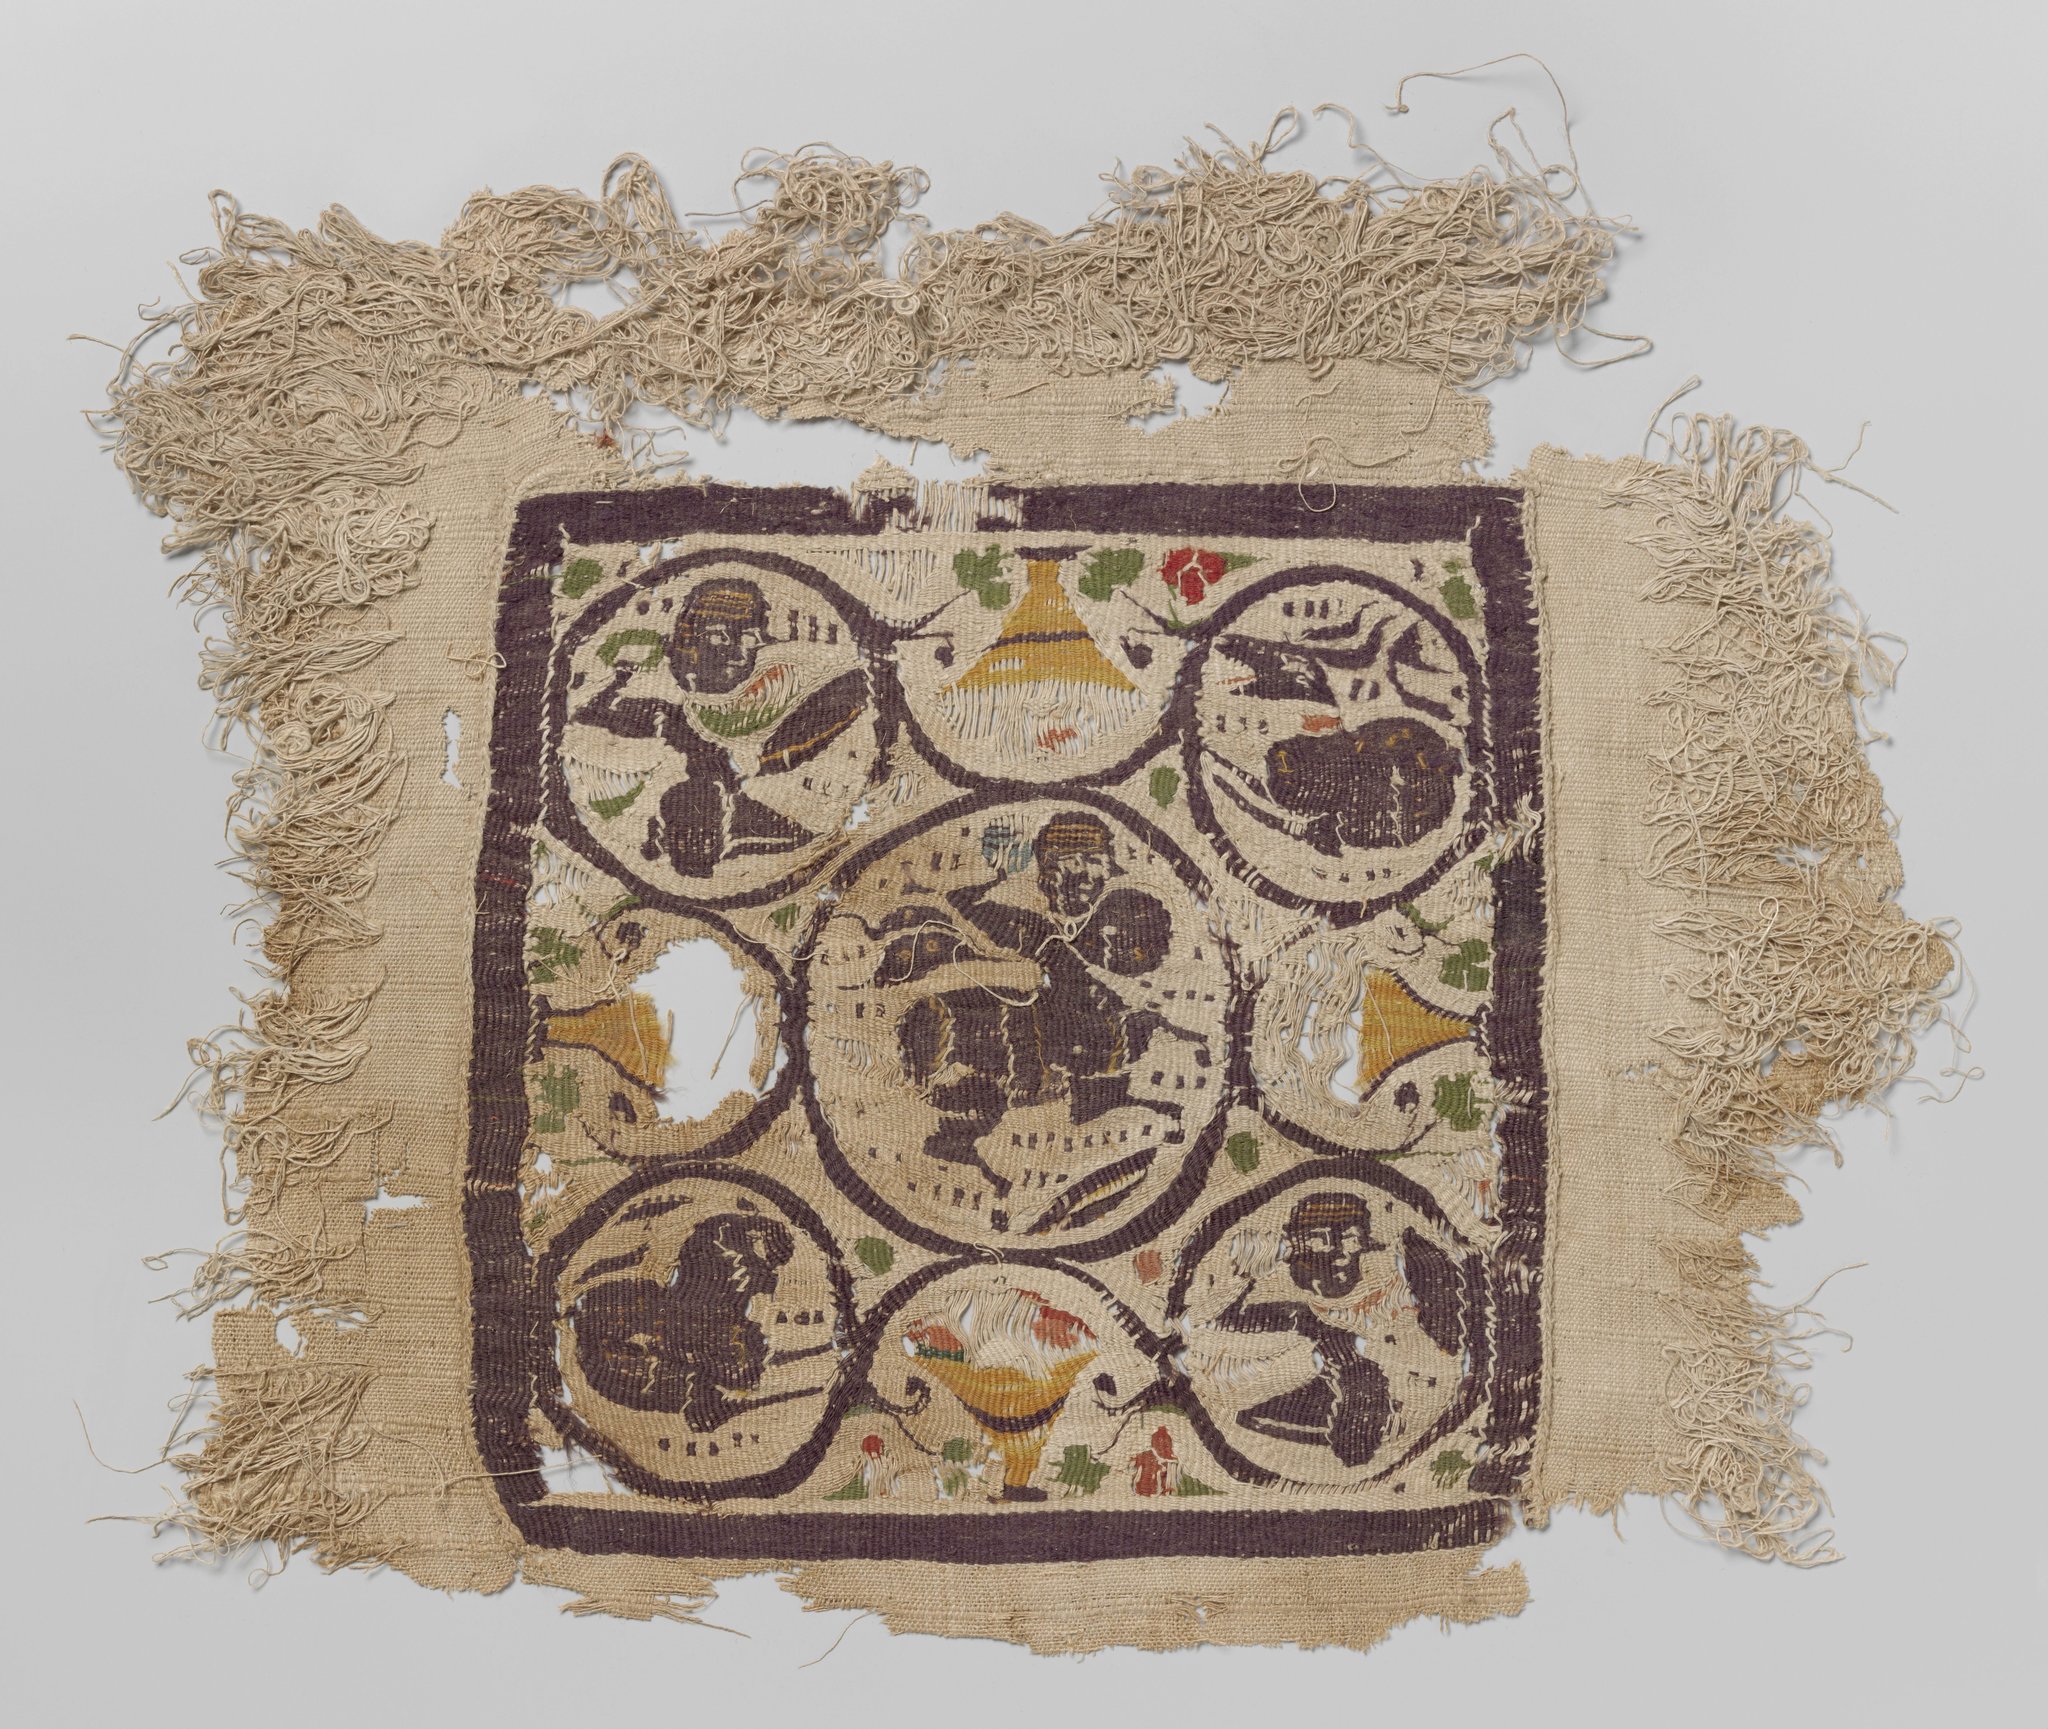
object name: tabula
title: Weefselfragment met tabula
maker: Anonymous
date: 300-699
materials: linen, wool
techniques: weave, tapestry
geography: egypt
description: Naturelkleurig linnen weefselfragment met ingeweven tabula met vijf cirkels in bordeauxrood. In de centrale cirkel een centaur, in de cirkels linksboven en rechtsonder een geknielde figuur met schild en krans, rechtsboven een liggend hert en linksonder een liggend dier, mogelijk een os. De vlakken tussen de cirkels zijn gevuld met gele bloemen- of vruchtenmanden. Her en der zijn kleuraccenten in rood, groen en blauw. Voor de detaillering is de vliegende draadtechniek gebruikt. Langs drie kanten zijn restanten van lussenweefsel aanwezig, wat wijst op mogelijk gebruik als kussen.